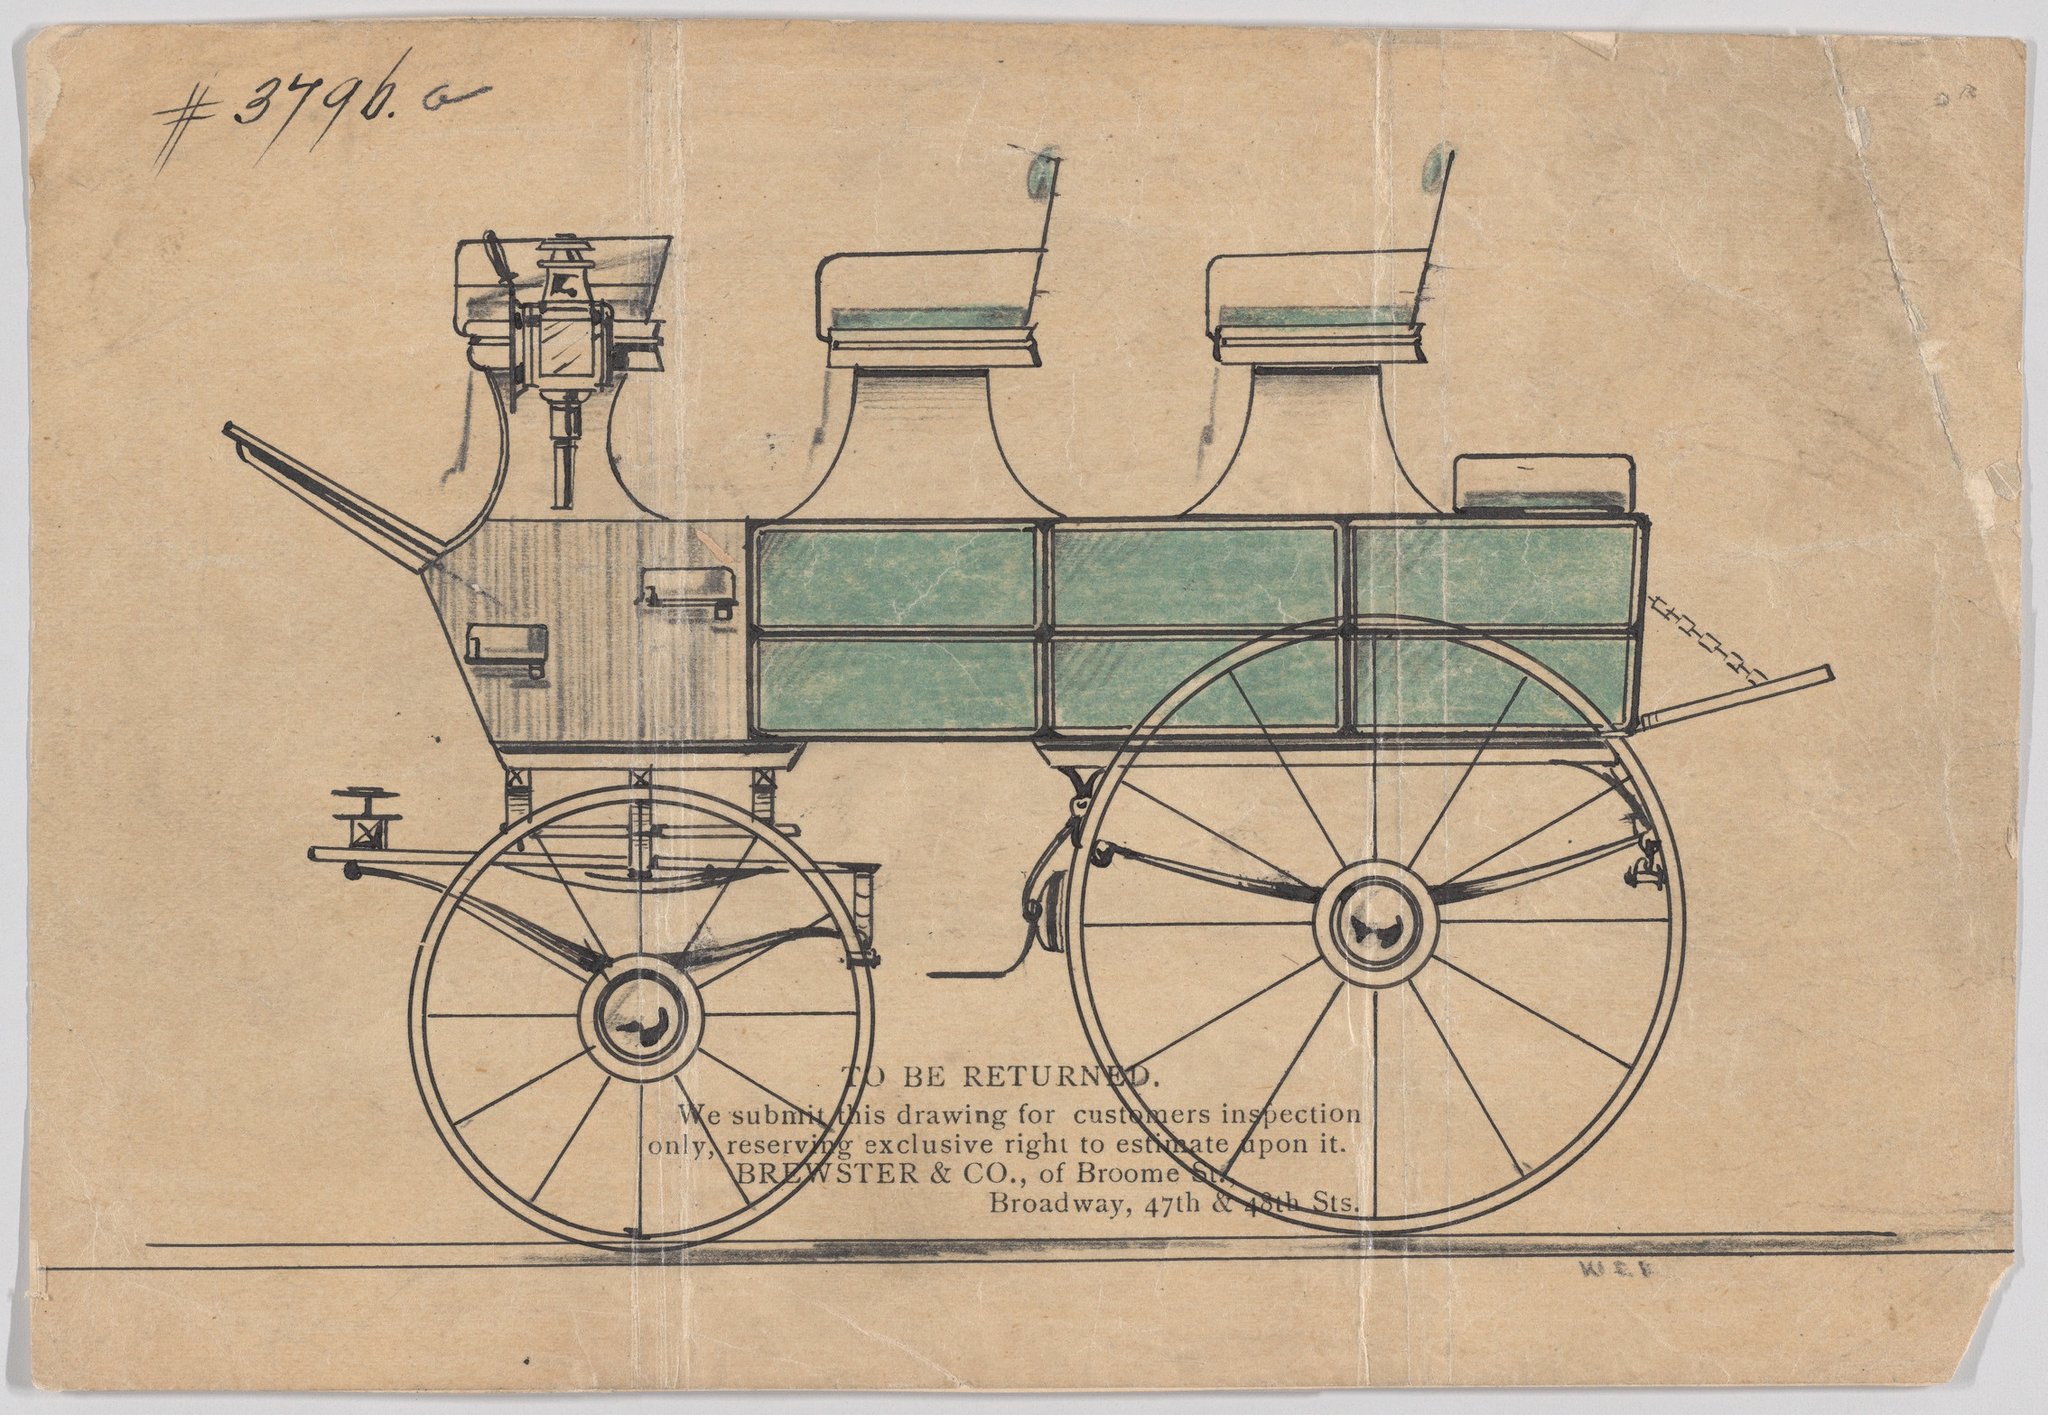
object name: drawing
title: Design for Roof Seat Break, no. 3796a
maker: brewster & co.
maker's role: manufacturer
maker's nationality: american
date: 1883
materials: gouache, graphite, ink, watercolor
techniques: pen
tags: carriages